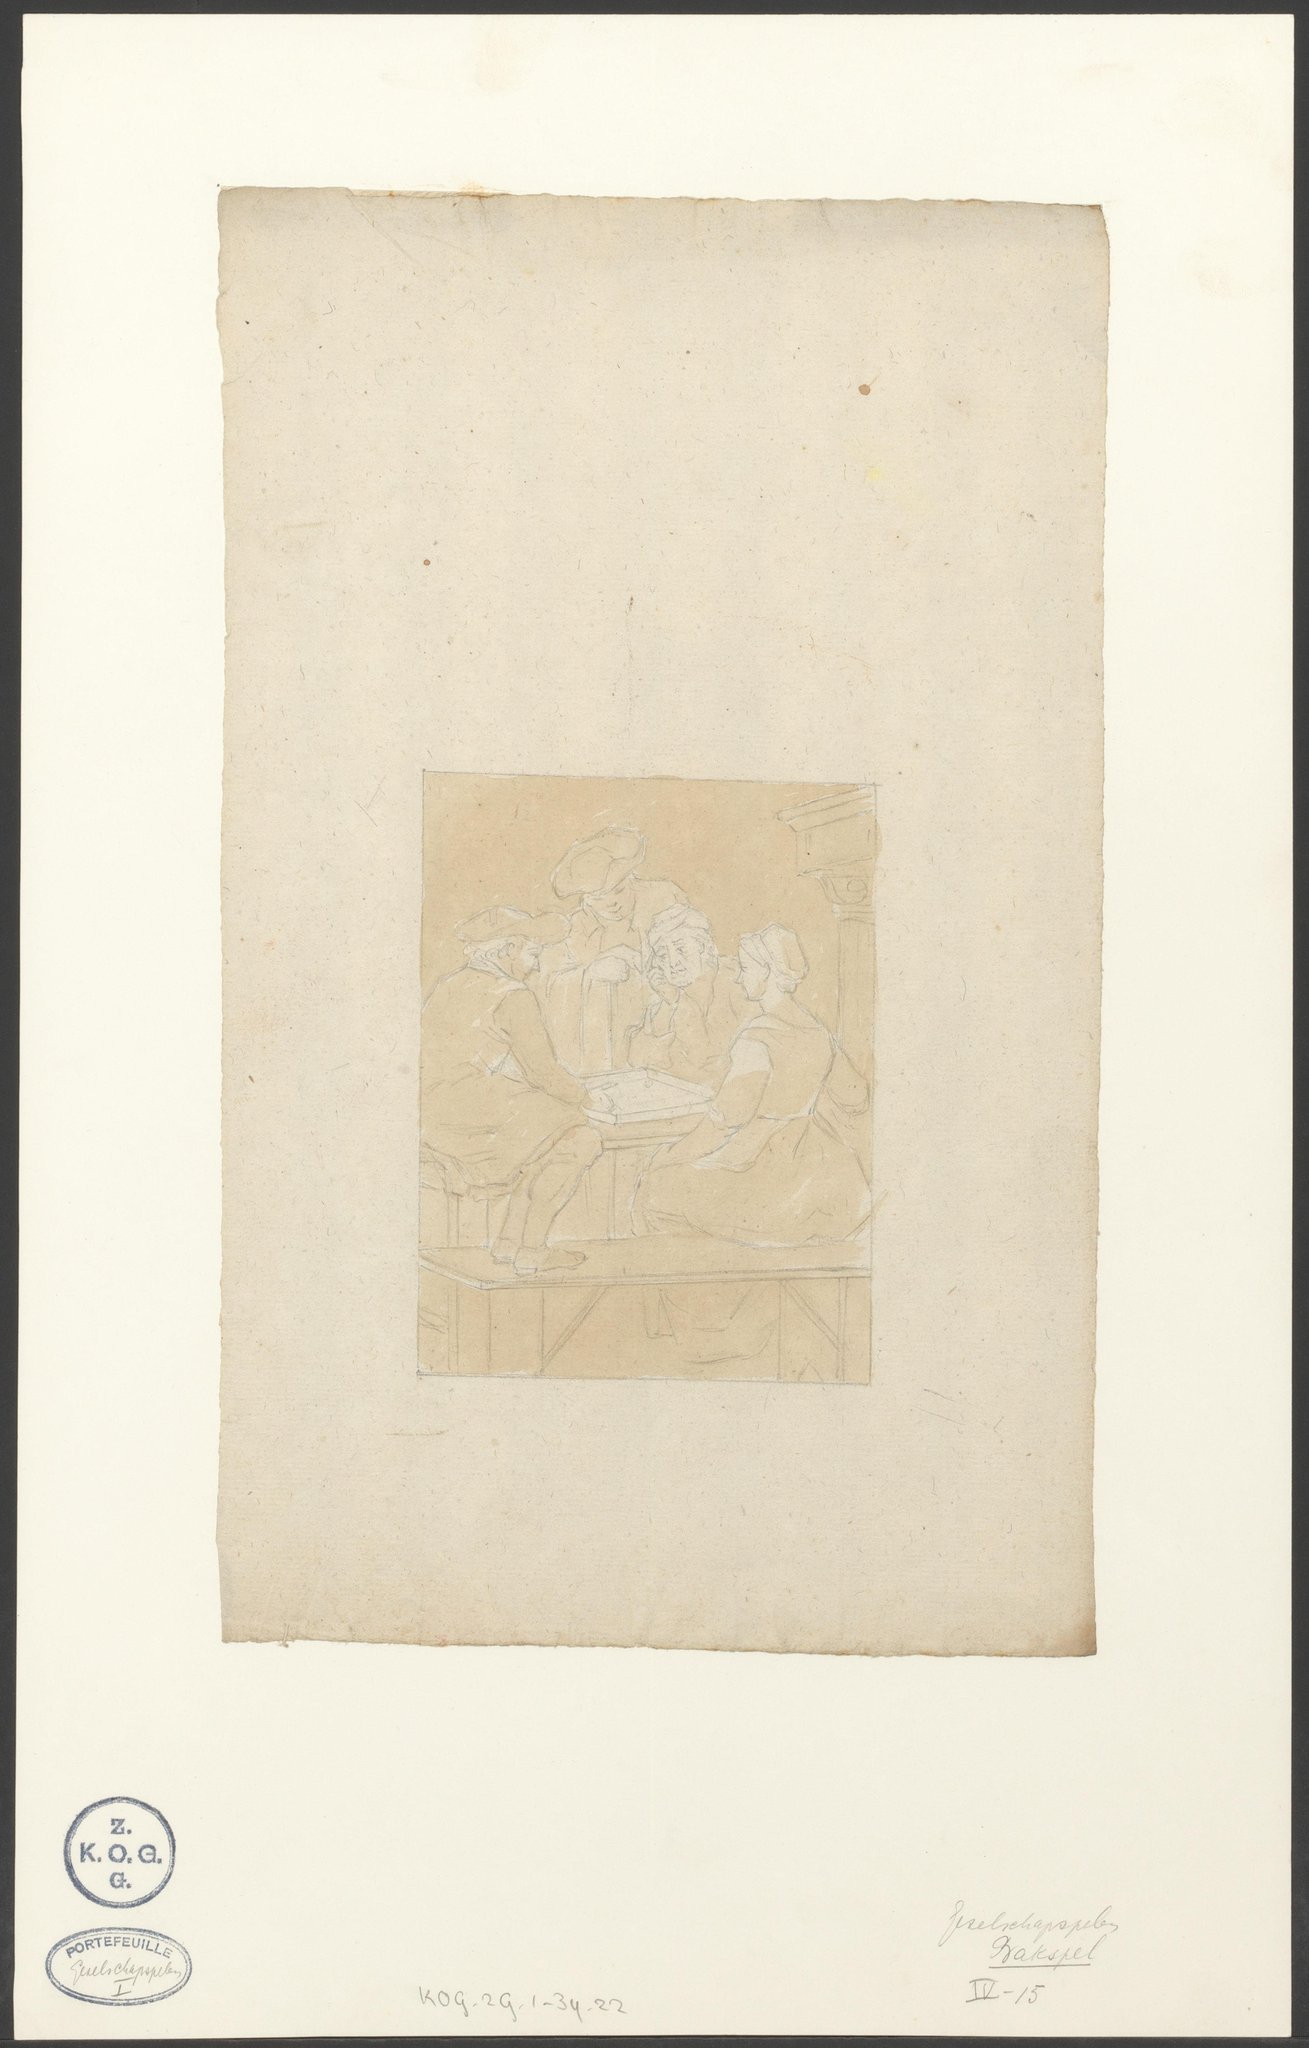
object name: drawing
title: Triktrakspelers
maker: Anonymous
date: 1750-1850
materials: ink, paper, pencil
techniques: brush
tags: backgammon, tric-trac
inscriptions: collector's mark: Lugt 1641, collector's mark